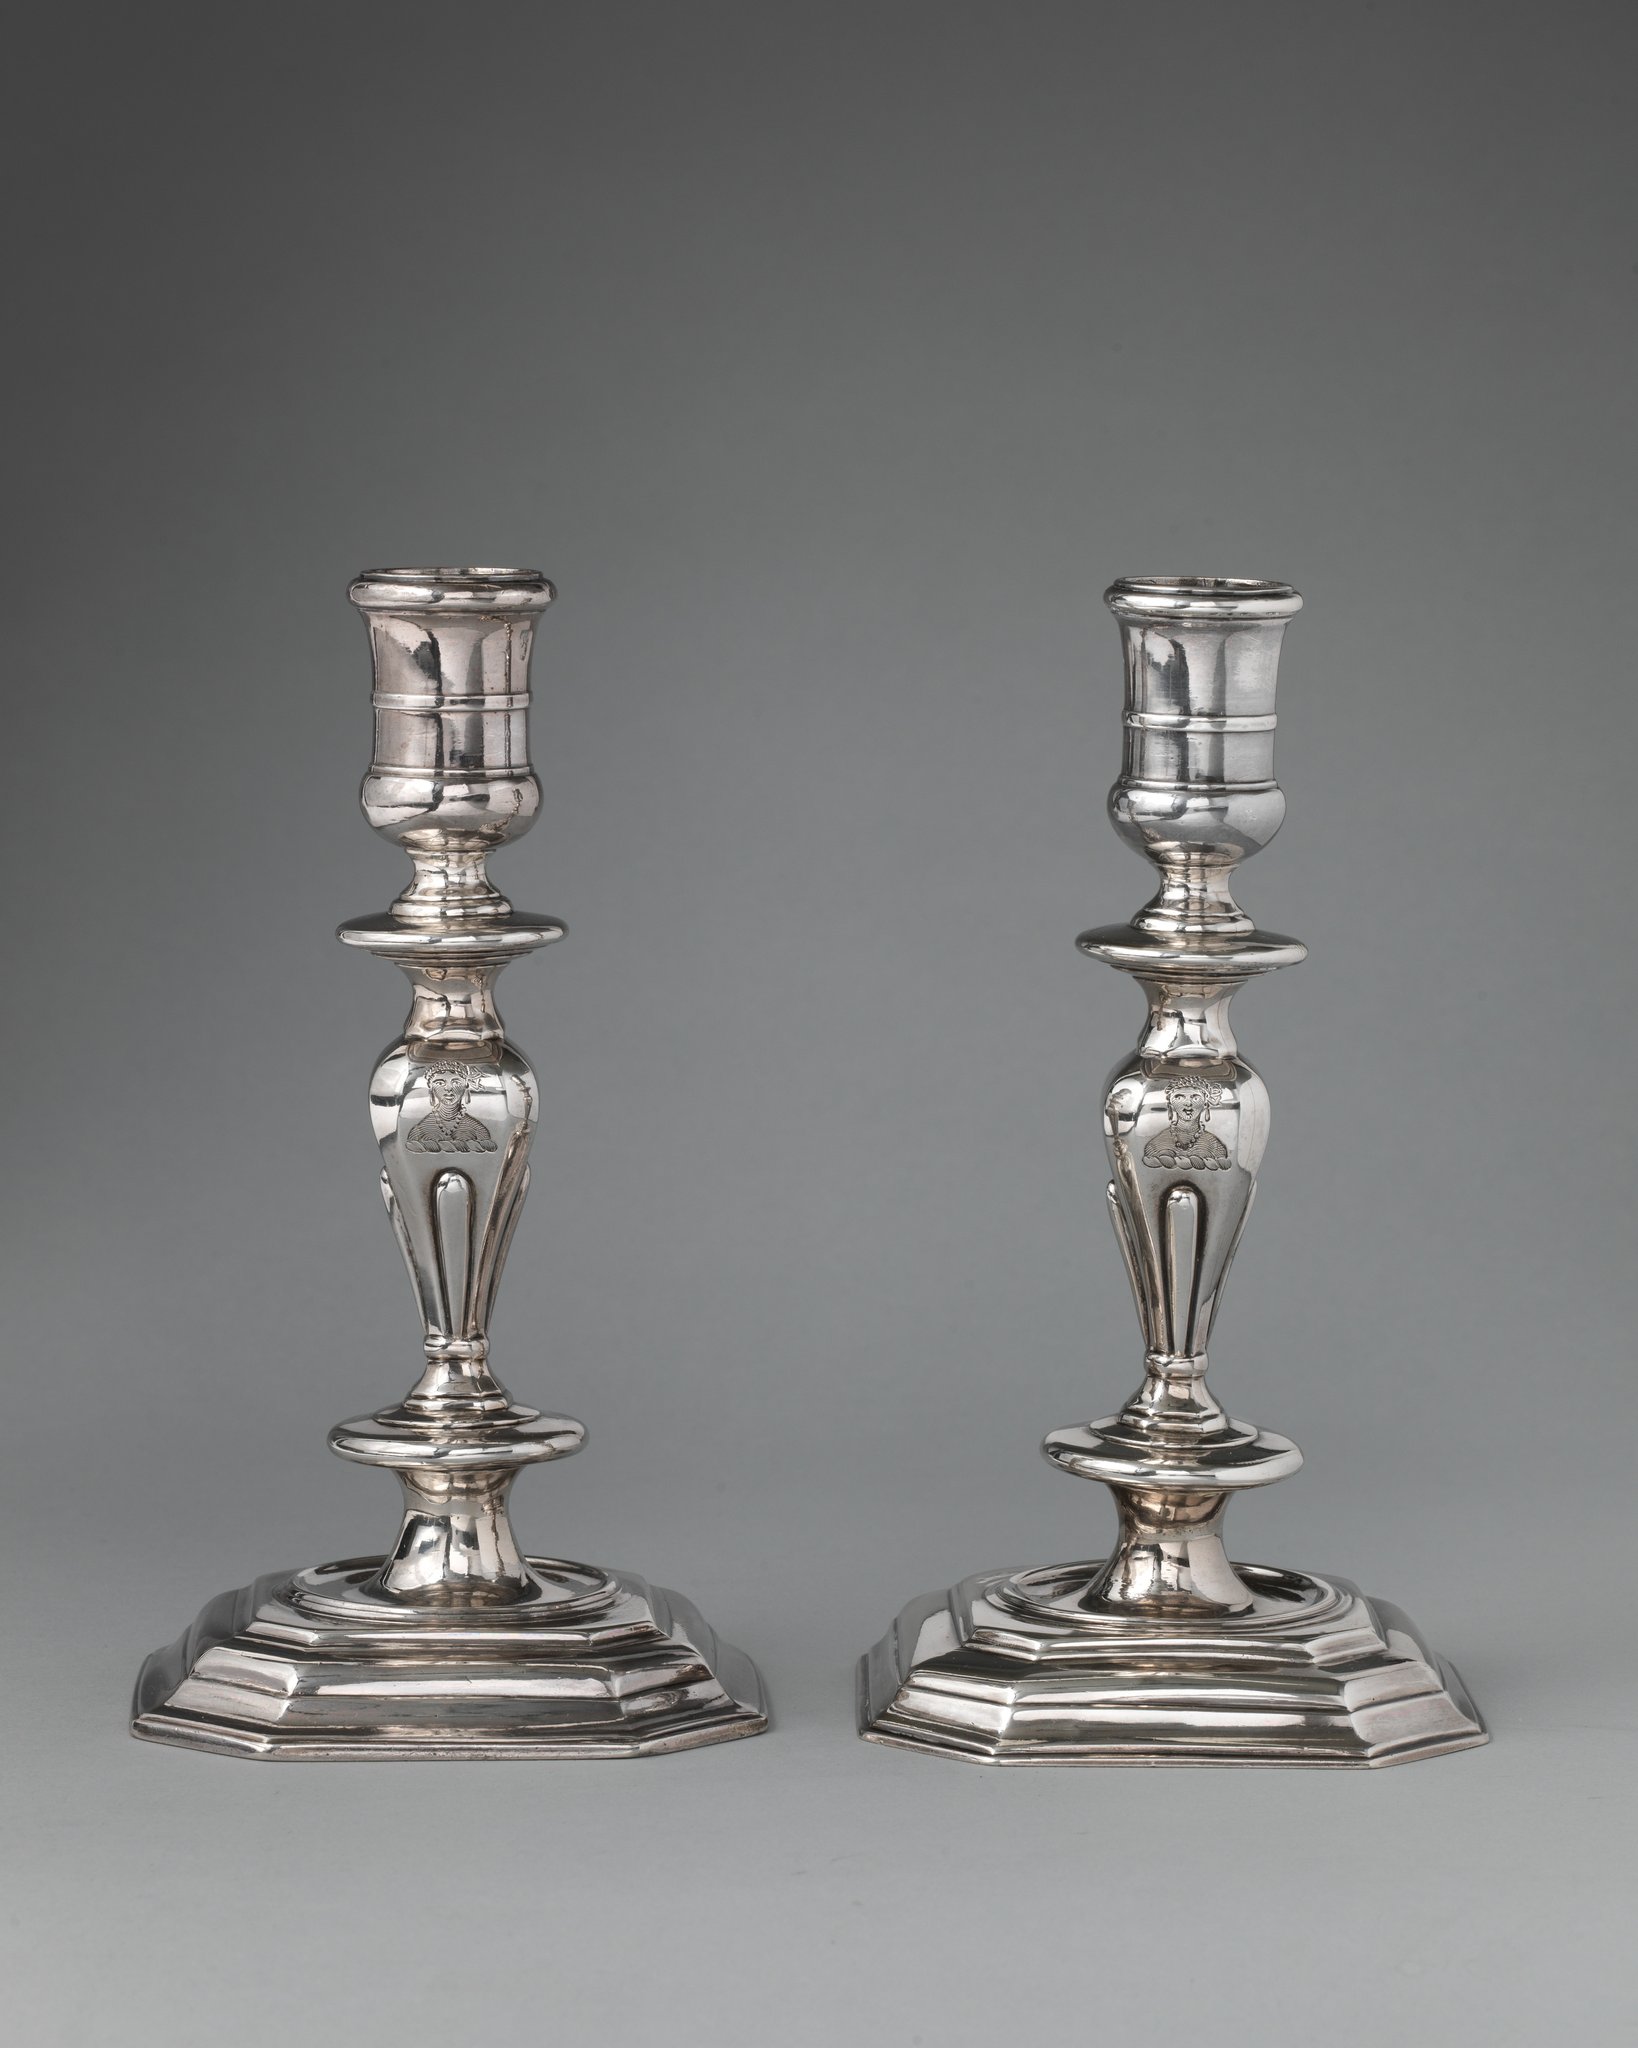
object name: candlestick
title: Pair of candlesticks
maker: thomas merry i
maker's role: maker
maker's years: 1701-1724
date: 1713-1714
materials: silver